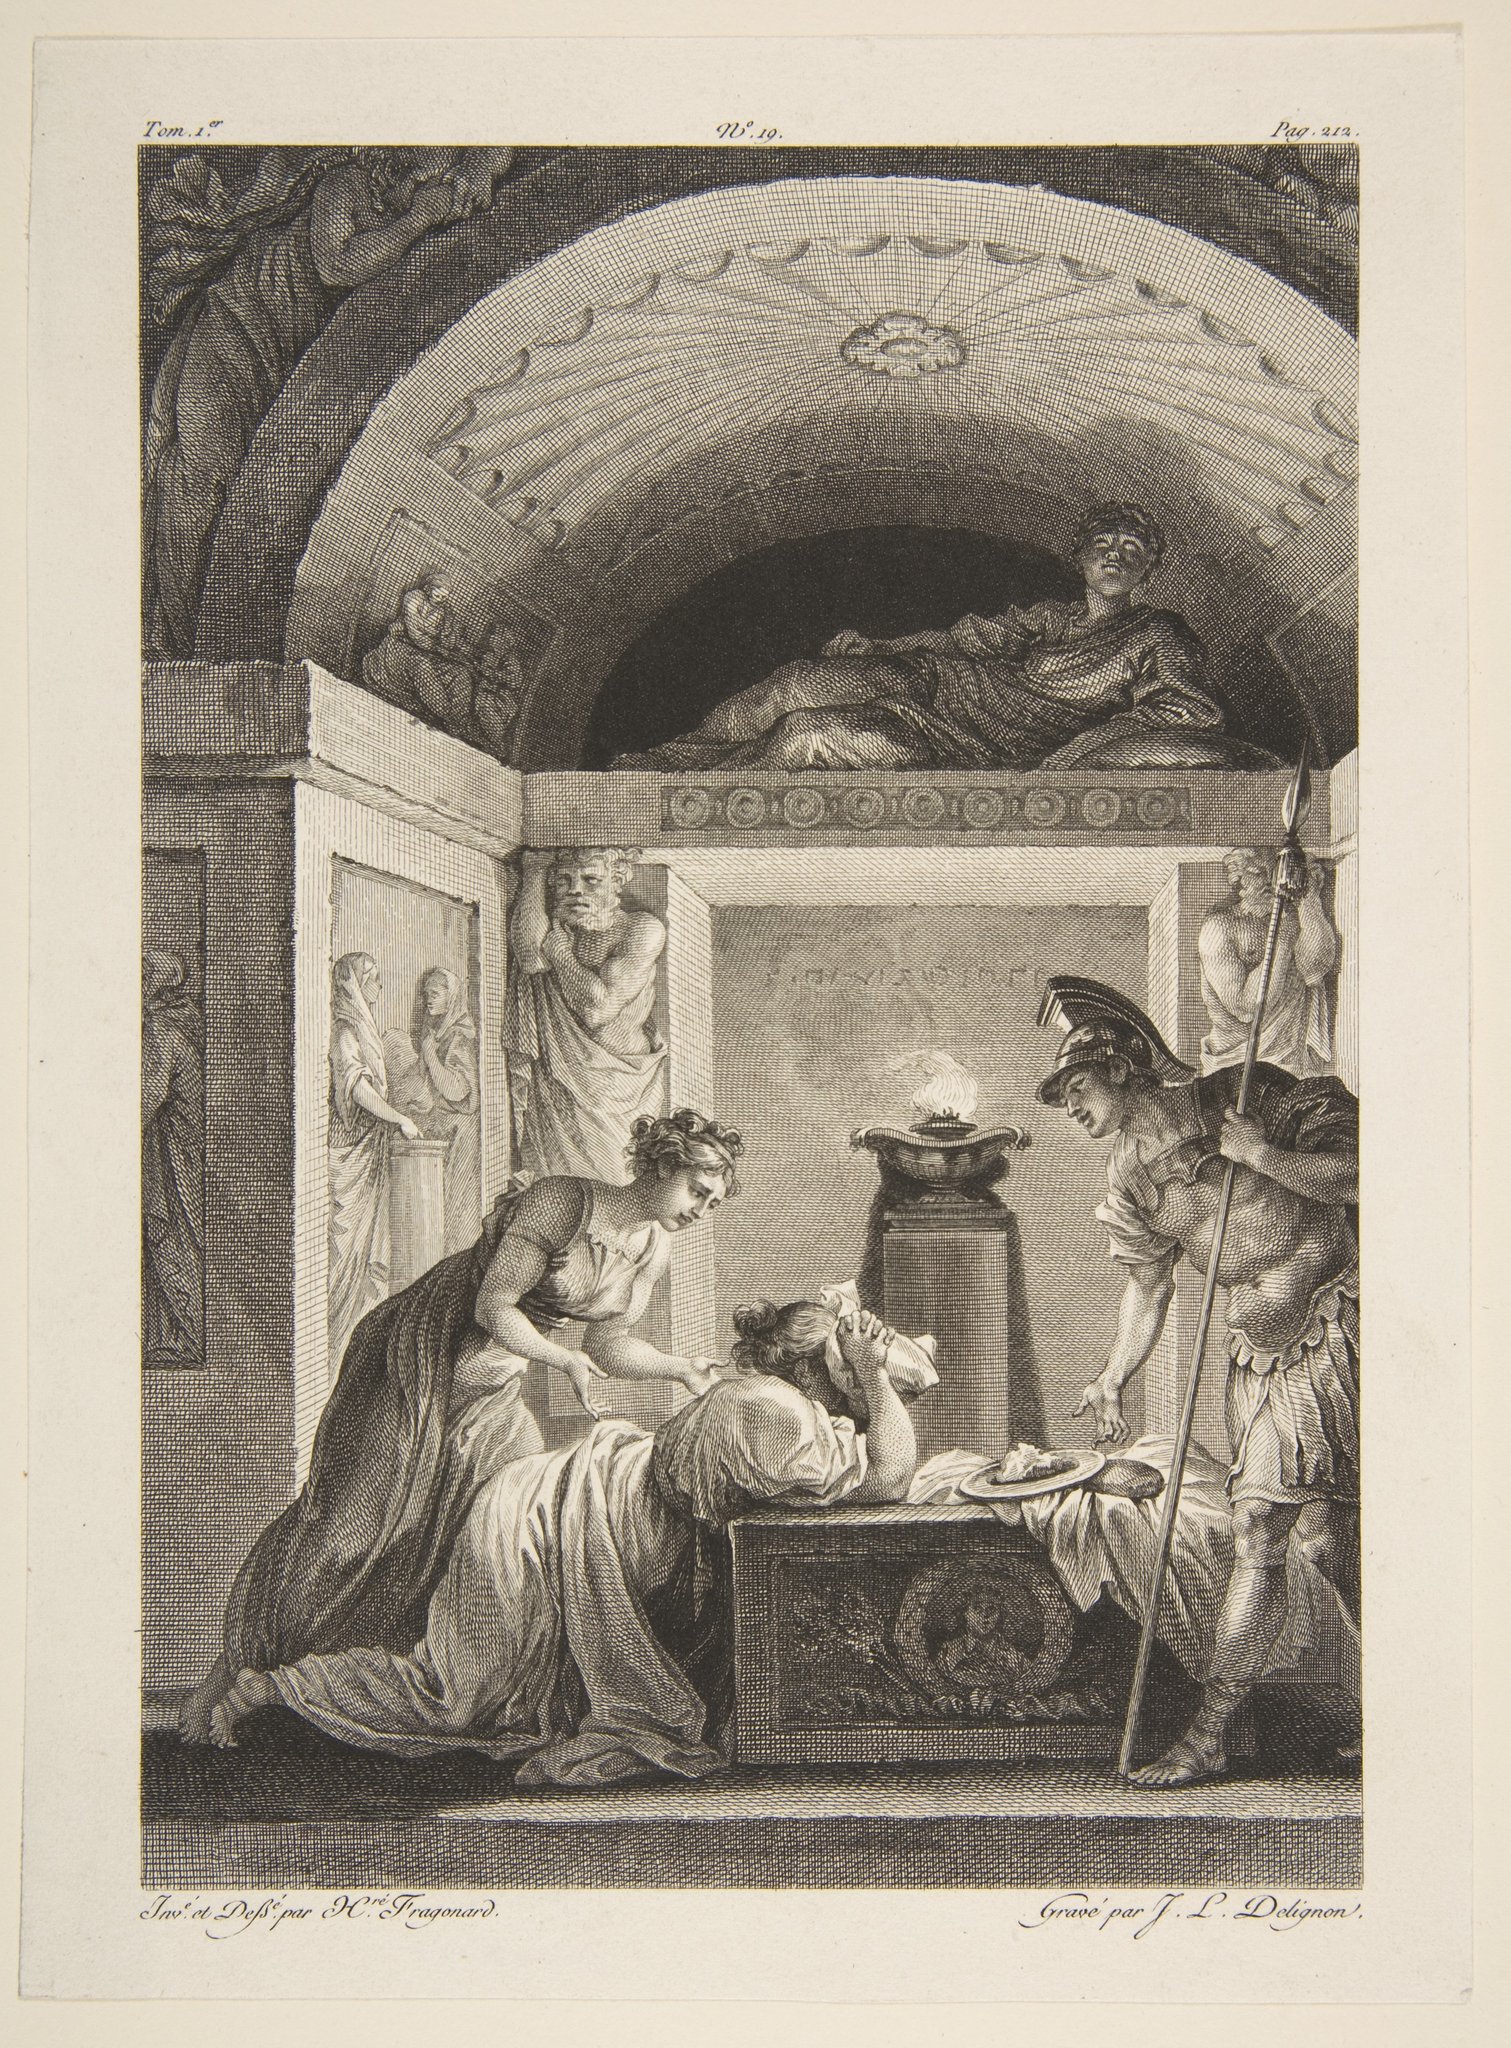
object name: print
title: La Matrone d'Ephese, from Contes et nouvelles en vers par Jean de La Fontaine. A Paris, de l'imprimerie de P. Didot, l'an III de la République, 1795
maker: jean-louis delignon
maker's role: artist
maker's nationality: french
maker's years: 1755-1804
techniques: engraving, etching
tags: soldiers,men,women